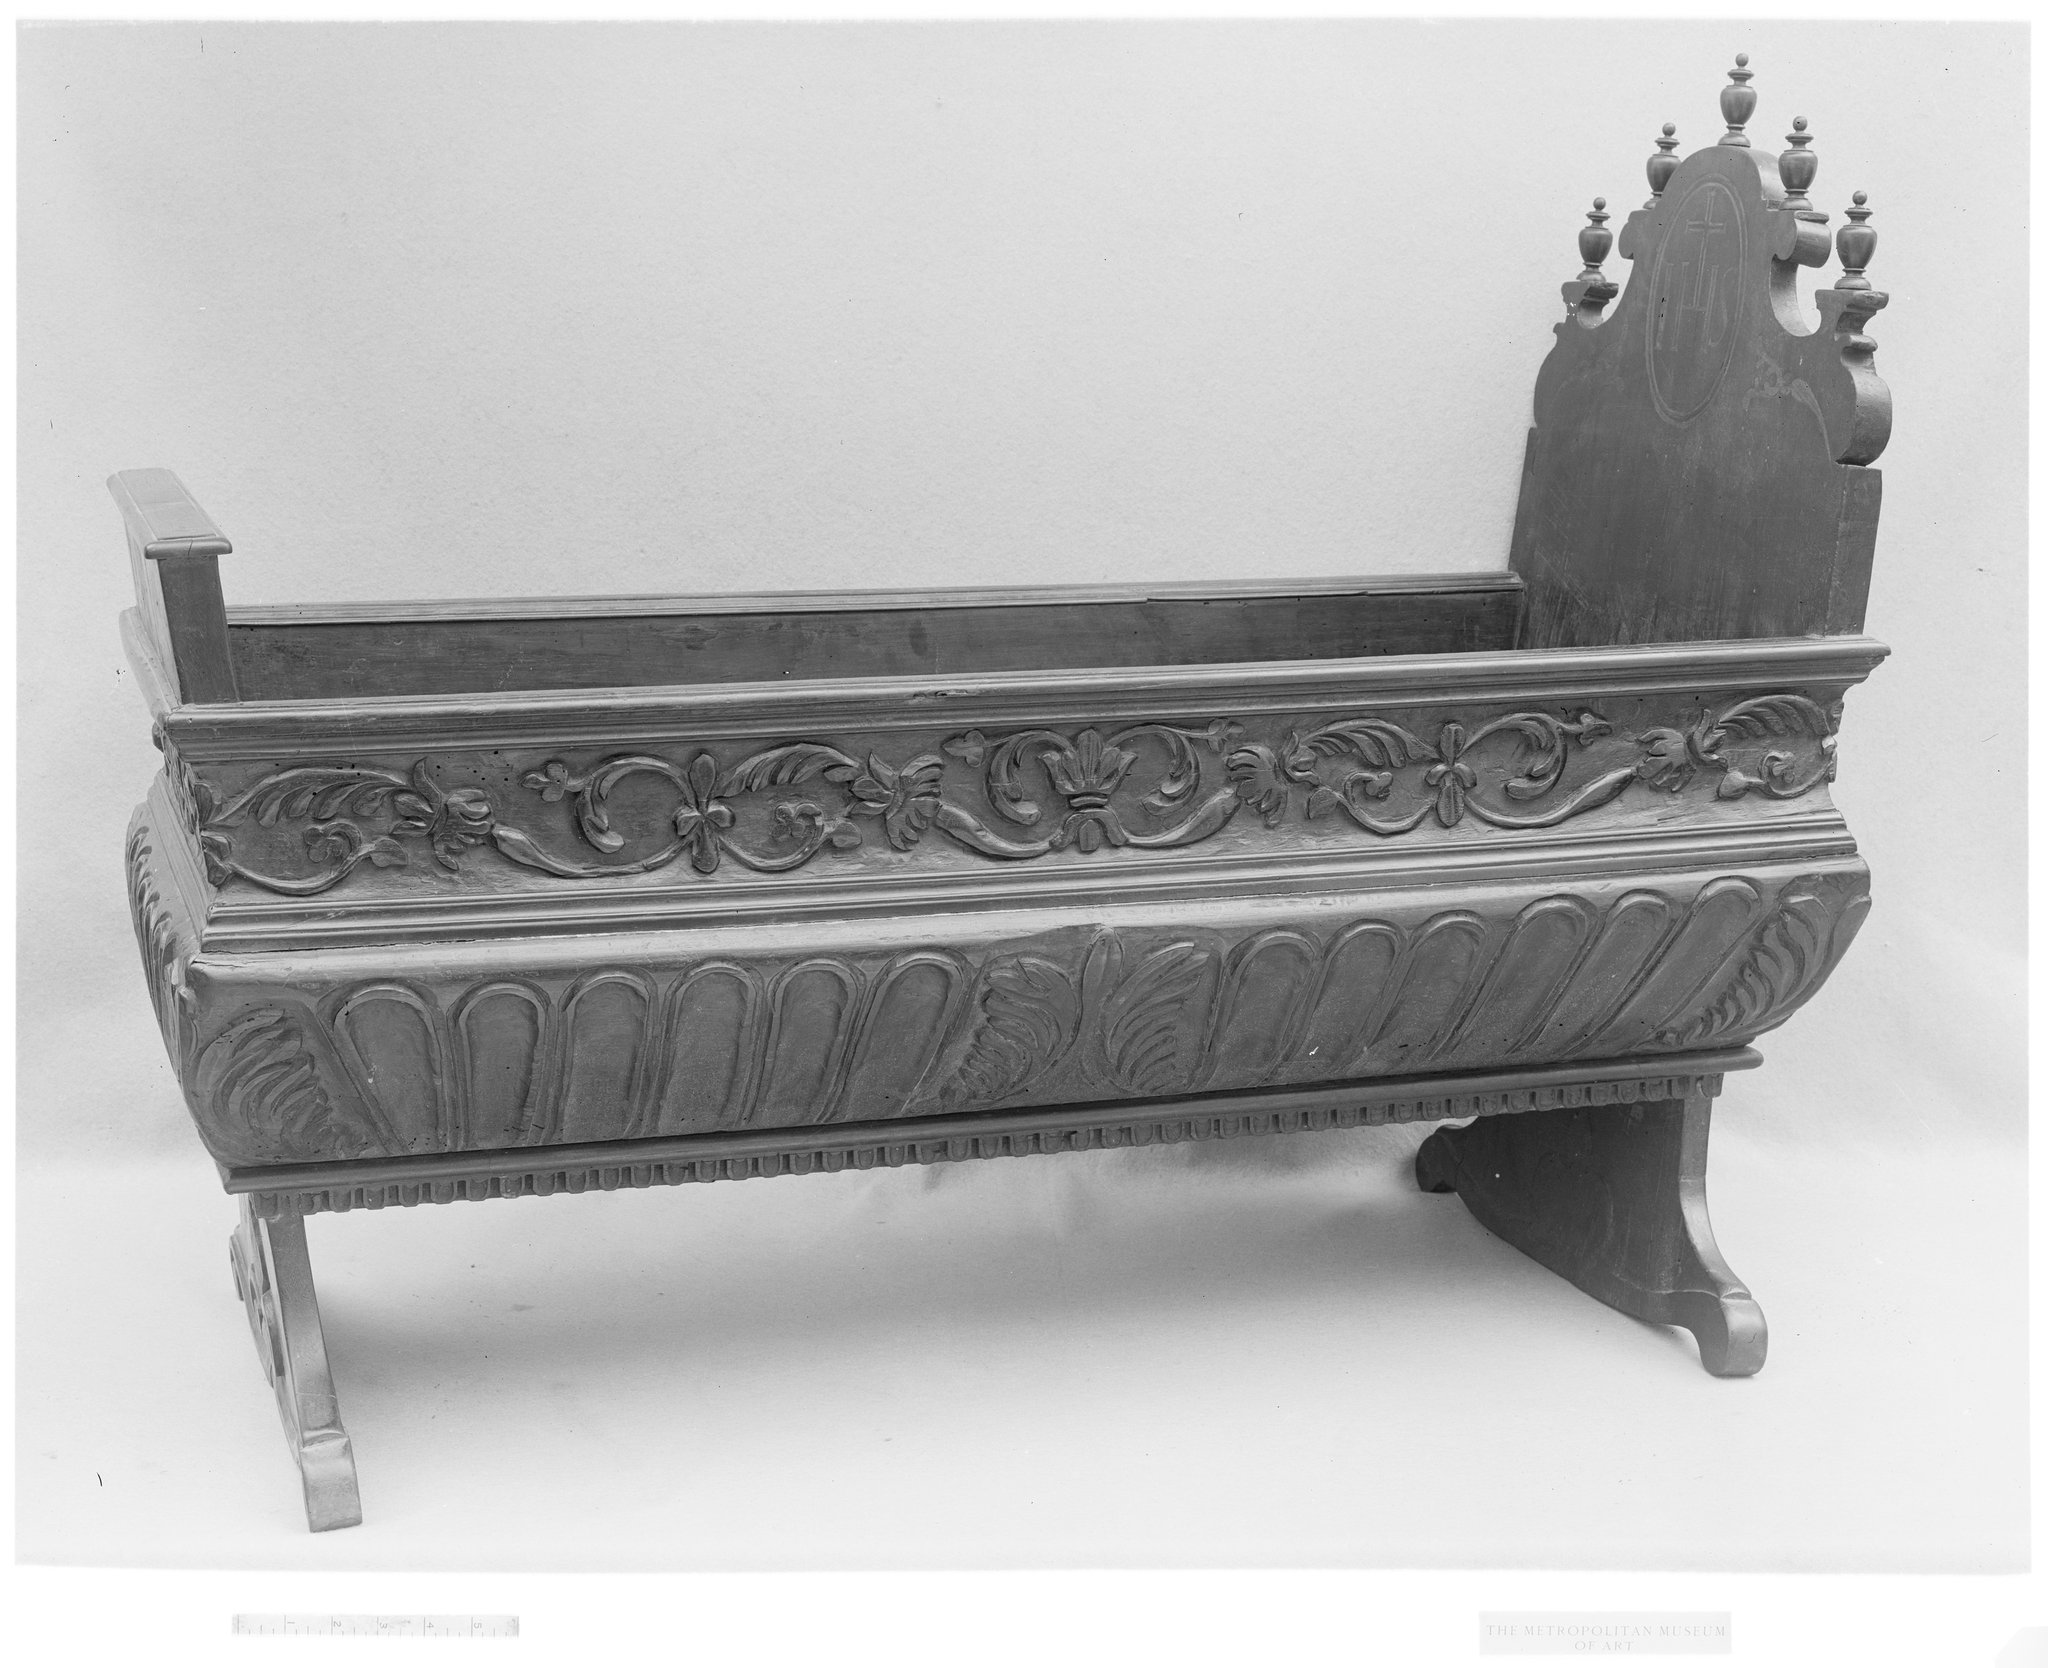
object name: cradle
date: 1501-1700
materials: wood